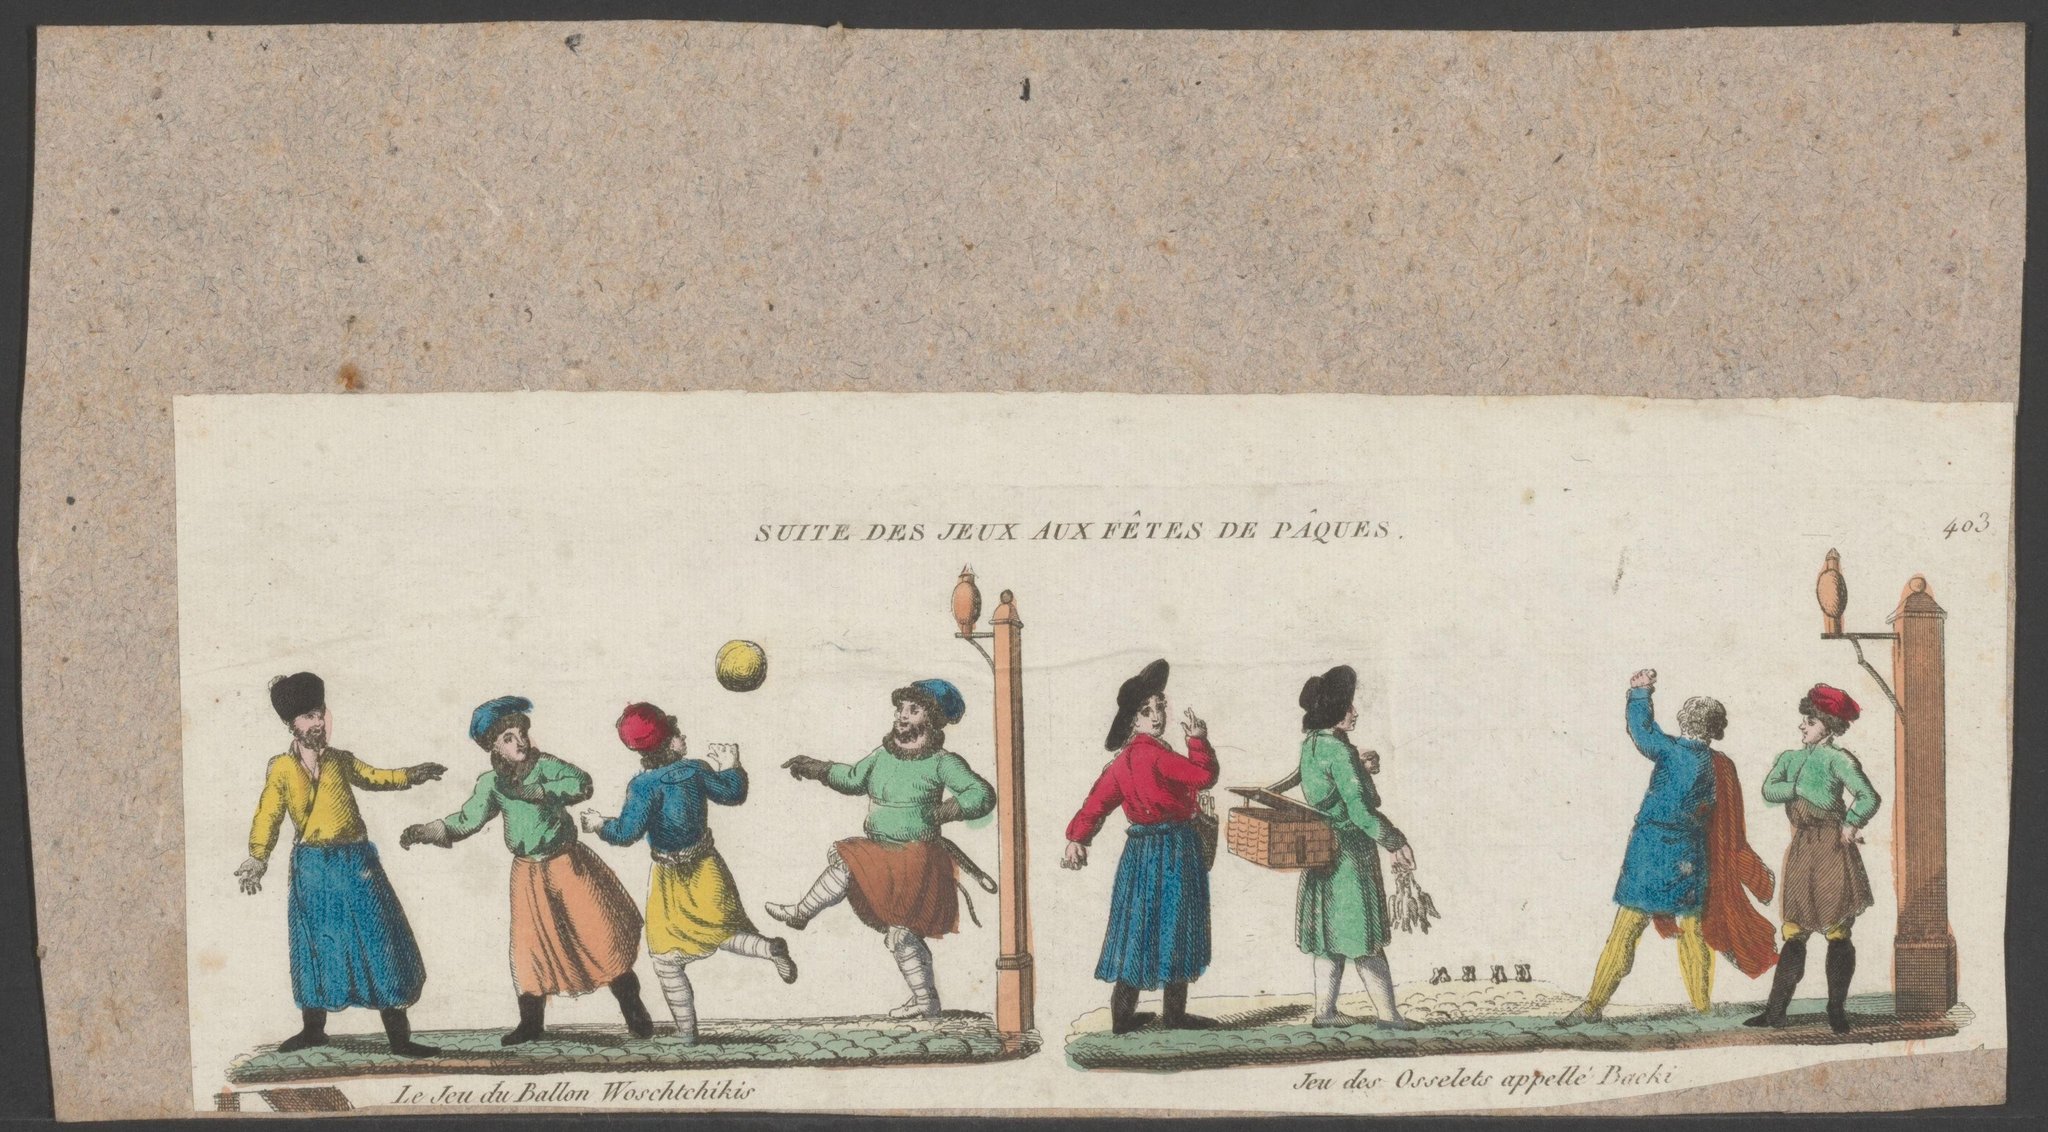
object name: print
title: Twee paasspellen uit Rusland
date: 1750-1865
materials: paper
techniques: engraving, etching, hand coloring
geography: paris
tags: sports, games and physical performances, russia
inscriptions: stamp, collector's mark: Lugt 1641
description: Rechtsboven genummerd: 403. Onderwerpsrubrieken binnen de Atlas Zeden en Gewoonten: Zeden en gewoonten in engeren zin, Des menschen begin, midden en einde, Kinderprenten opgeplakt op karton.